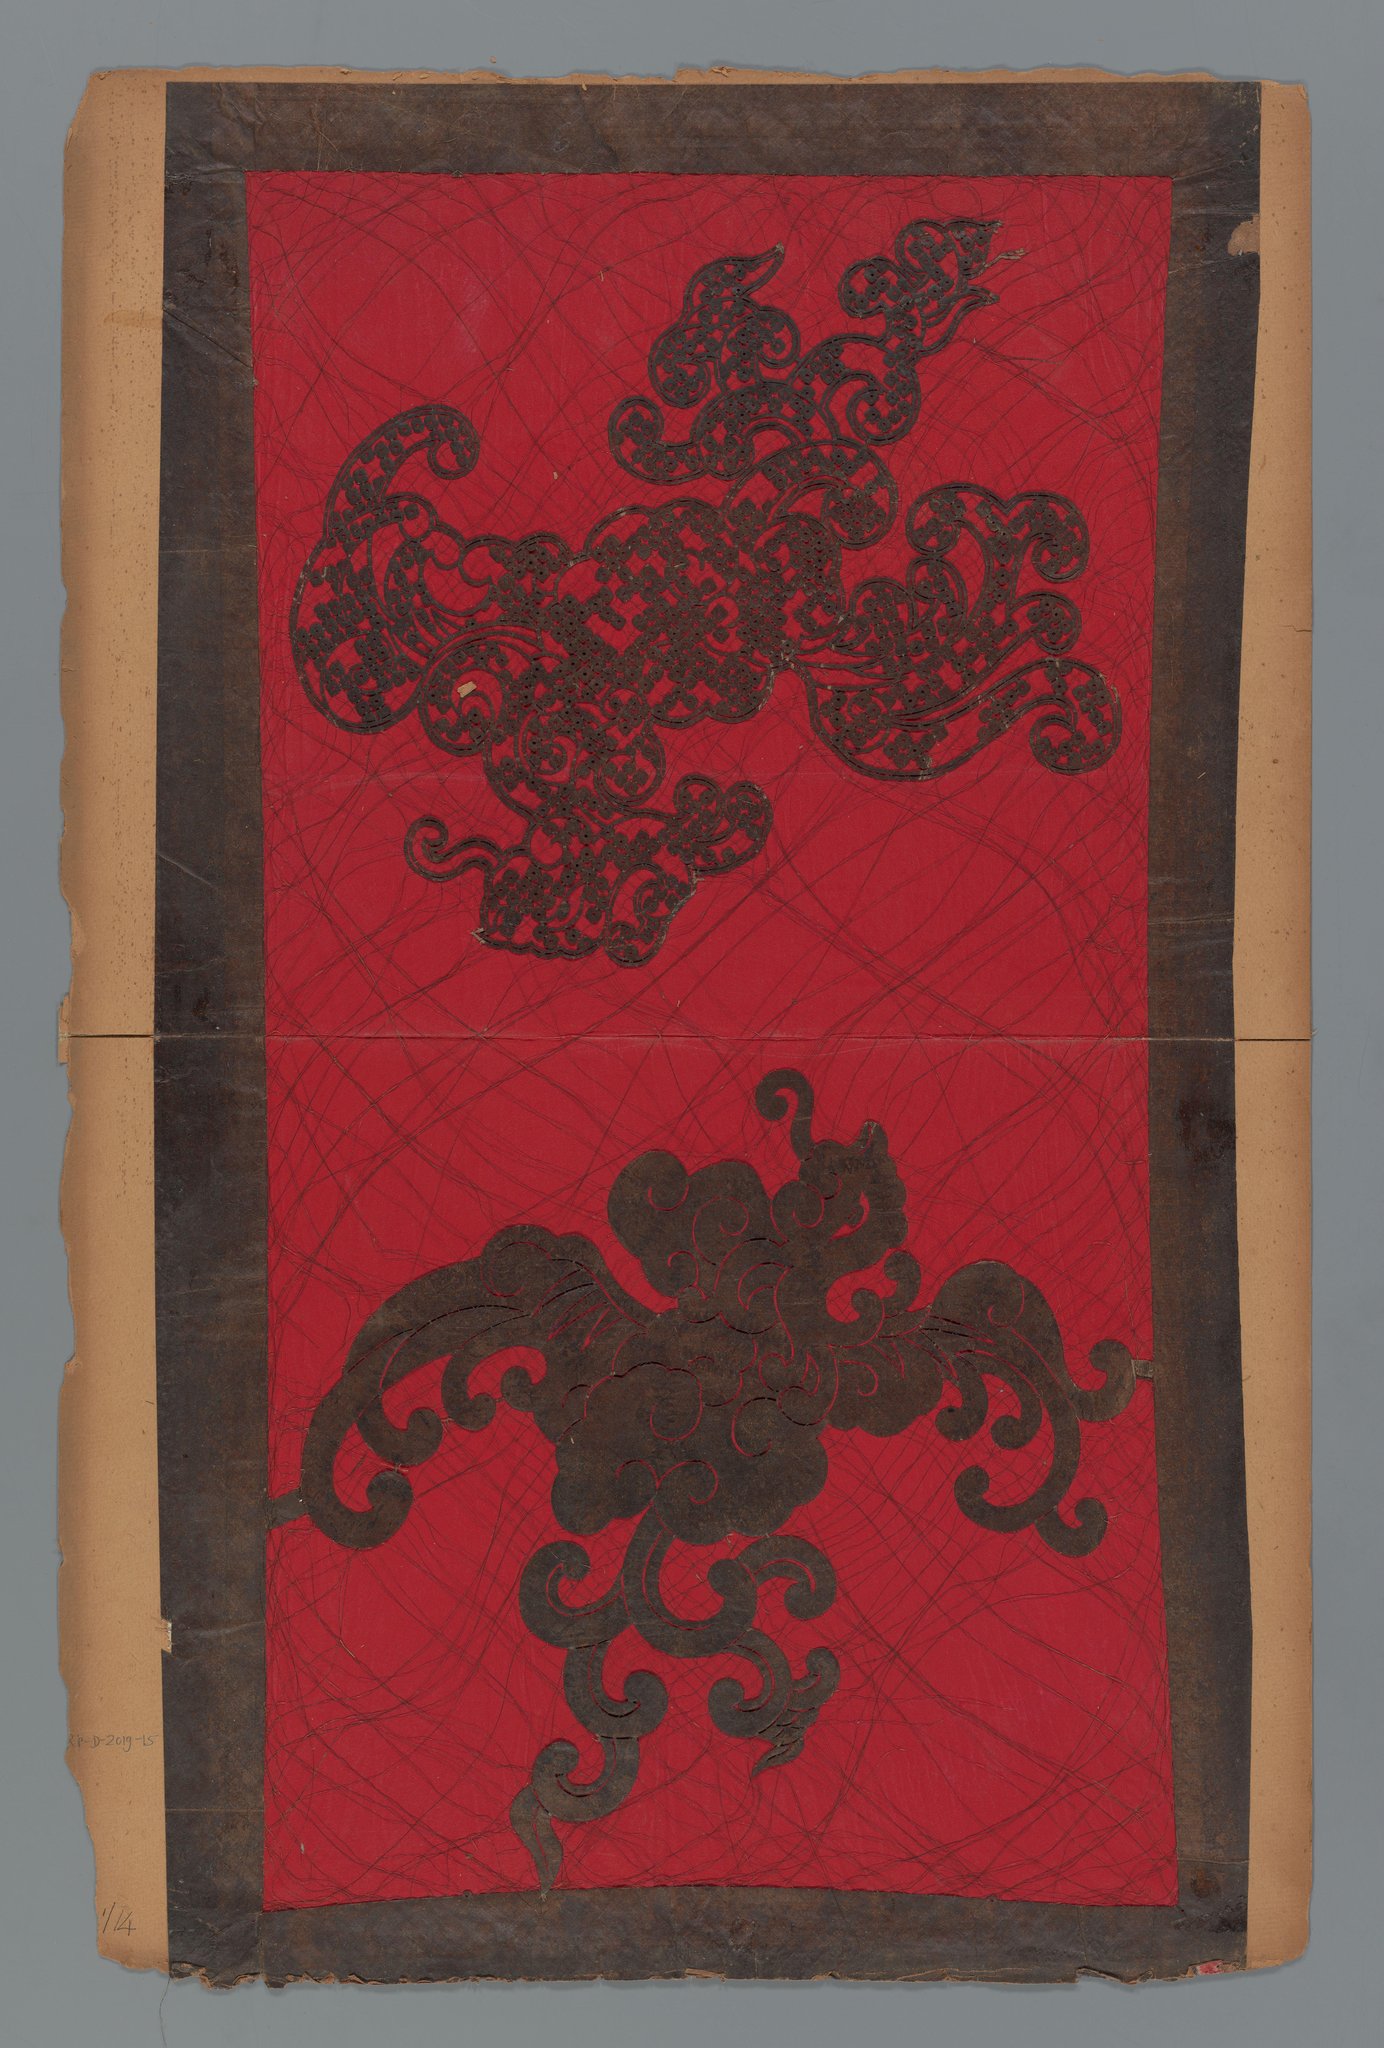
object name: katagami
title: Sjabloon met twee abstracte krulornamenten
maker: Anonymous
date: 1800-1909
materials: paper, silk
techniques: cutting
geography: japan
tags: ornament ~ round and curved forms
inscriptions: number: ‘1/14’, stamp: ‘Afgeschreven W...’, stamp: ‘Museum van Kunstnijverheid Haarlem’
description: Japanse sjabloon (katagami) met een patroon van twee abstracte krulornamenten, waarvan één fijn is uitgesneden.